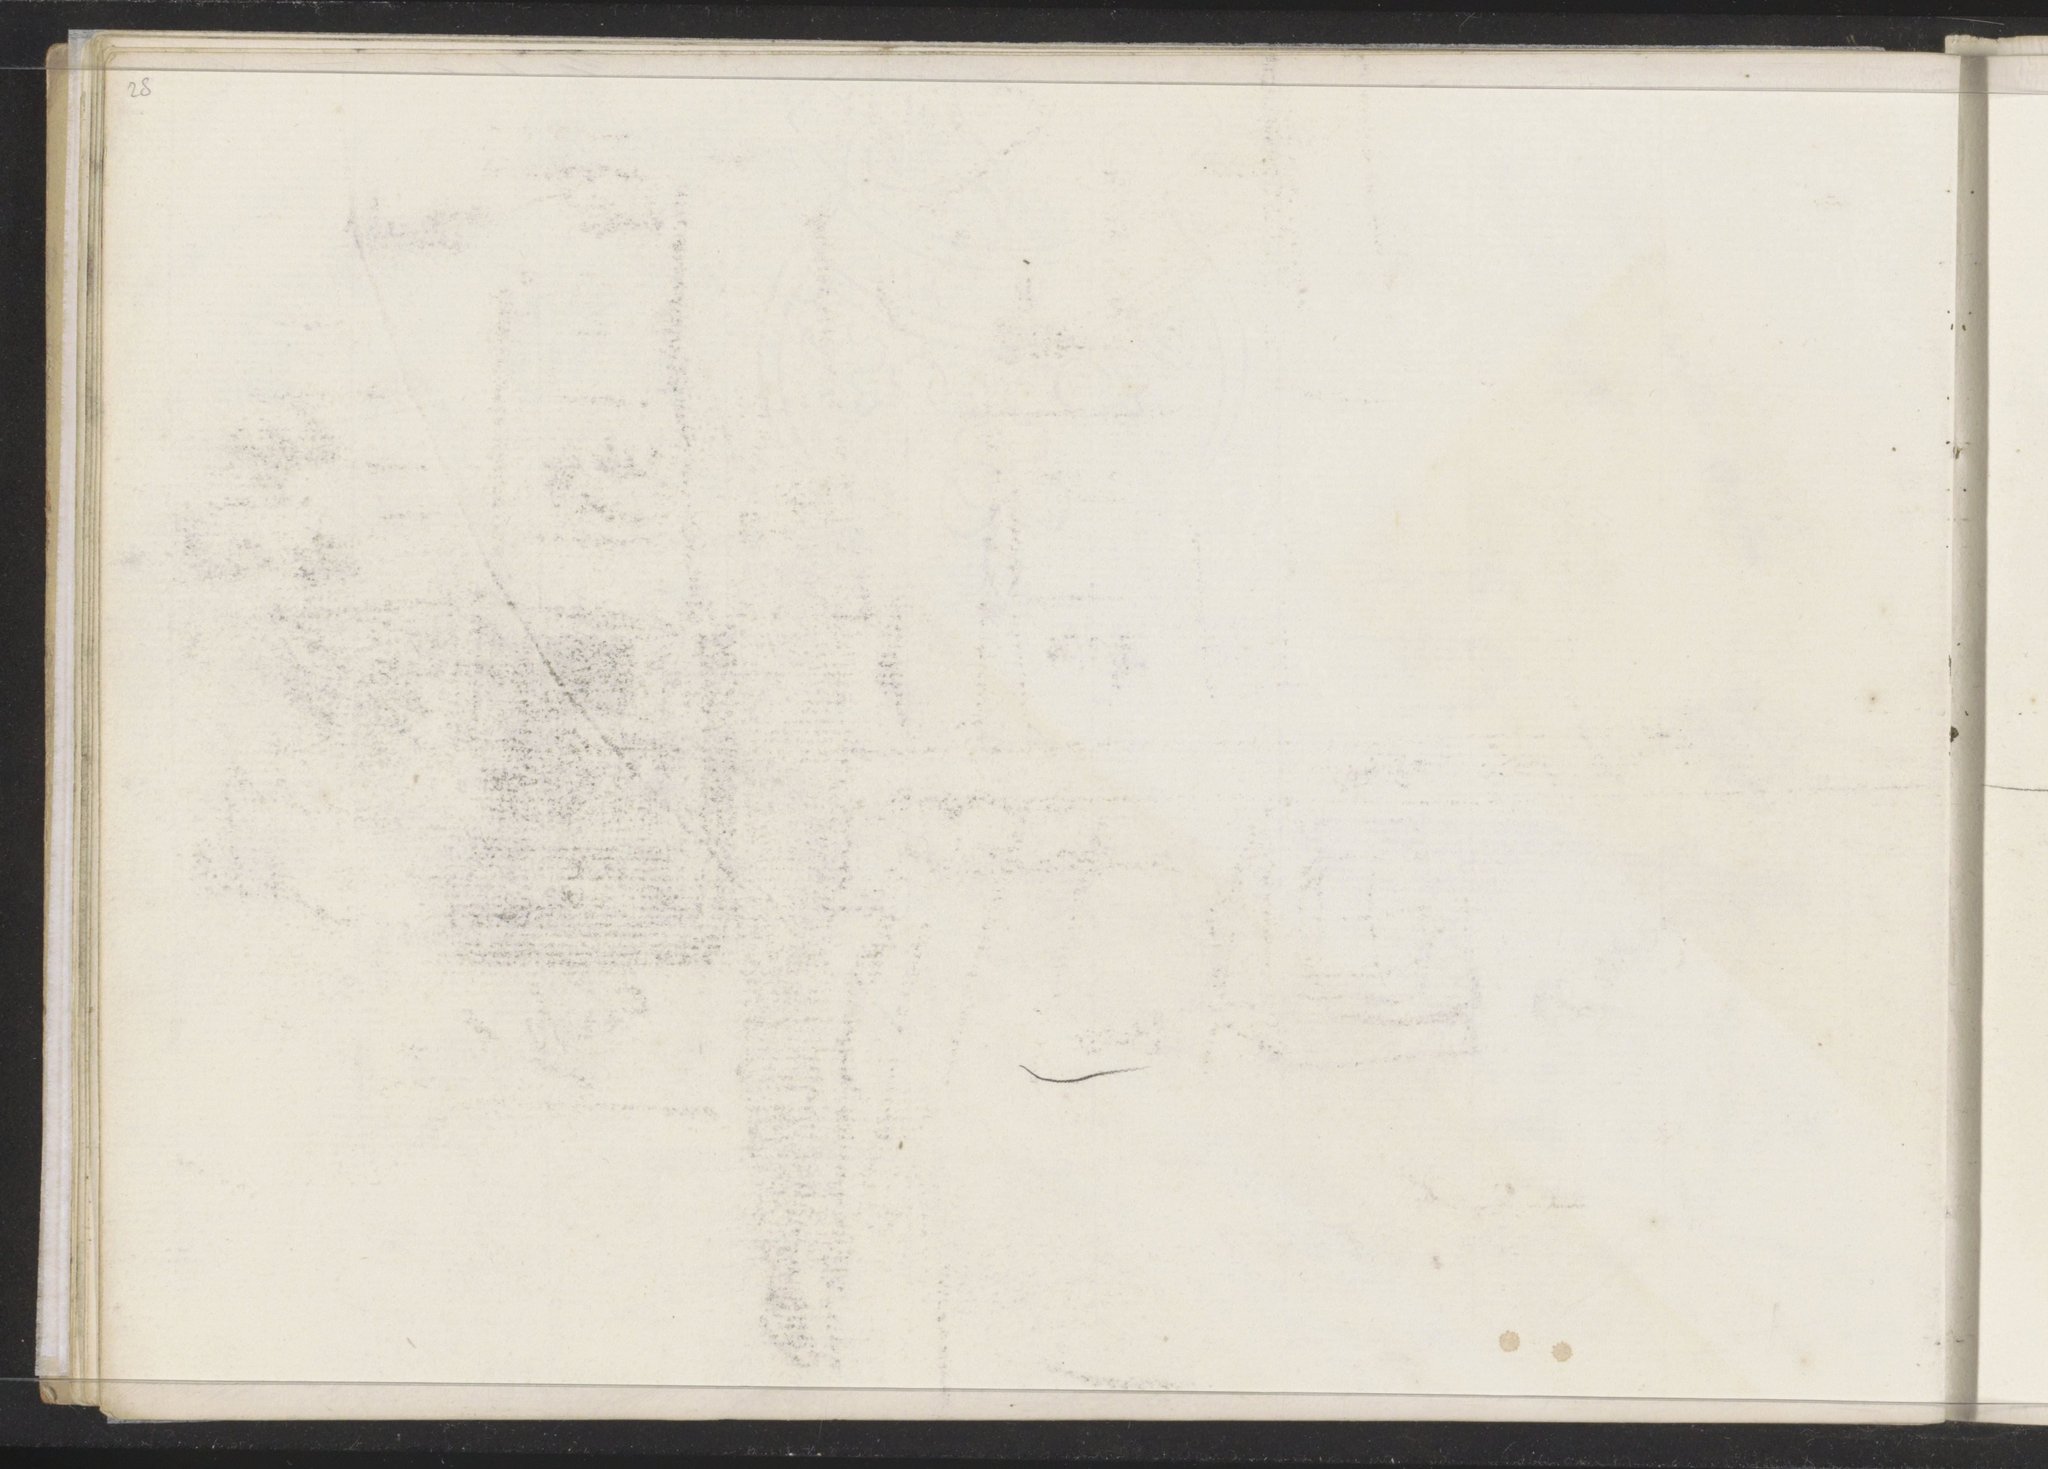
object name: sketchbook leaf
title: Abklatsch van de krijttekening op pagina 29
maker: willem witsen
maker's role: draughtsman, painter, print maker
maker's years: 1860-1923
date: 1897-1899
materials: paper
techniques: printmaking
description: Pagina 28 uit een schetsboek met 17 bladen.